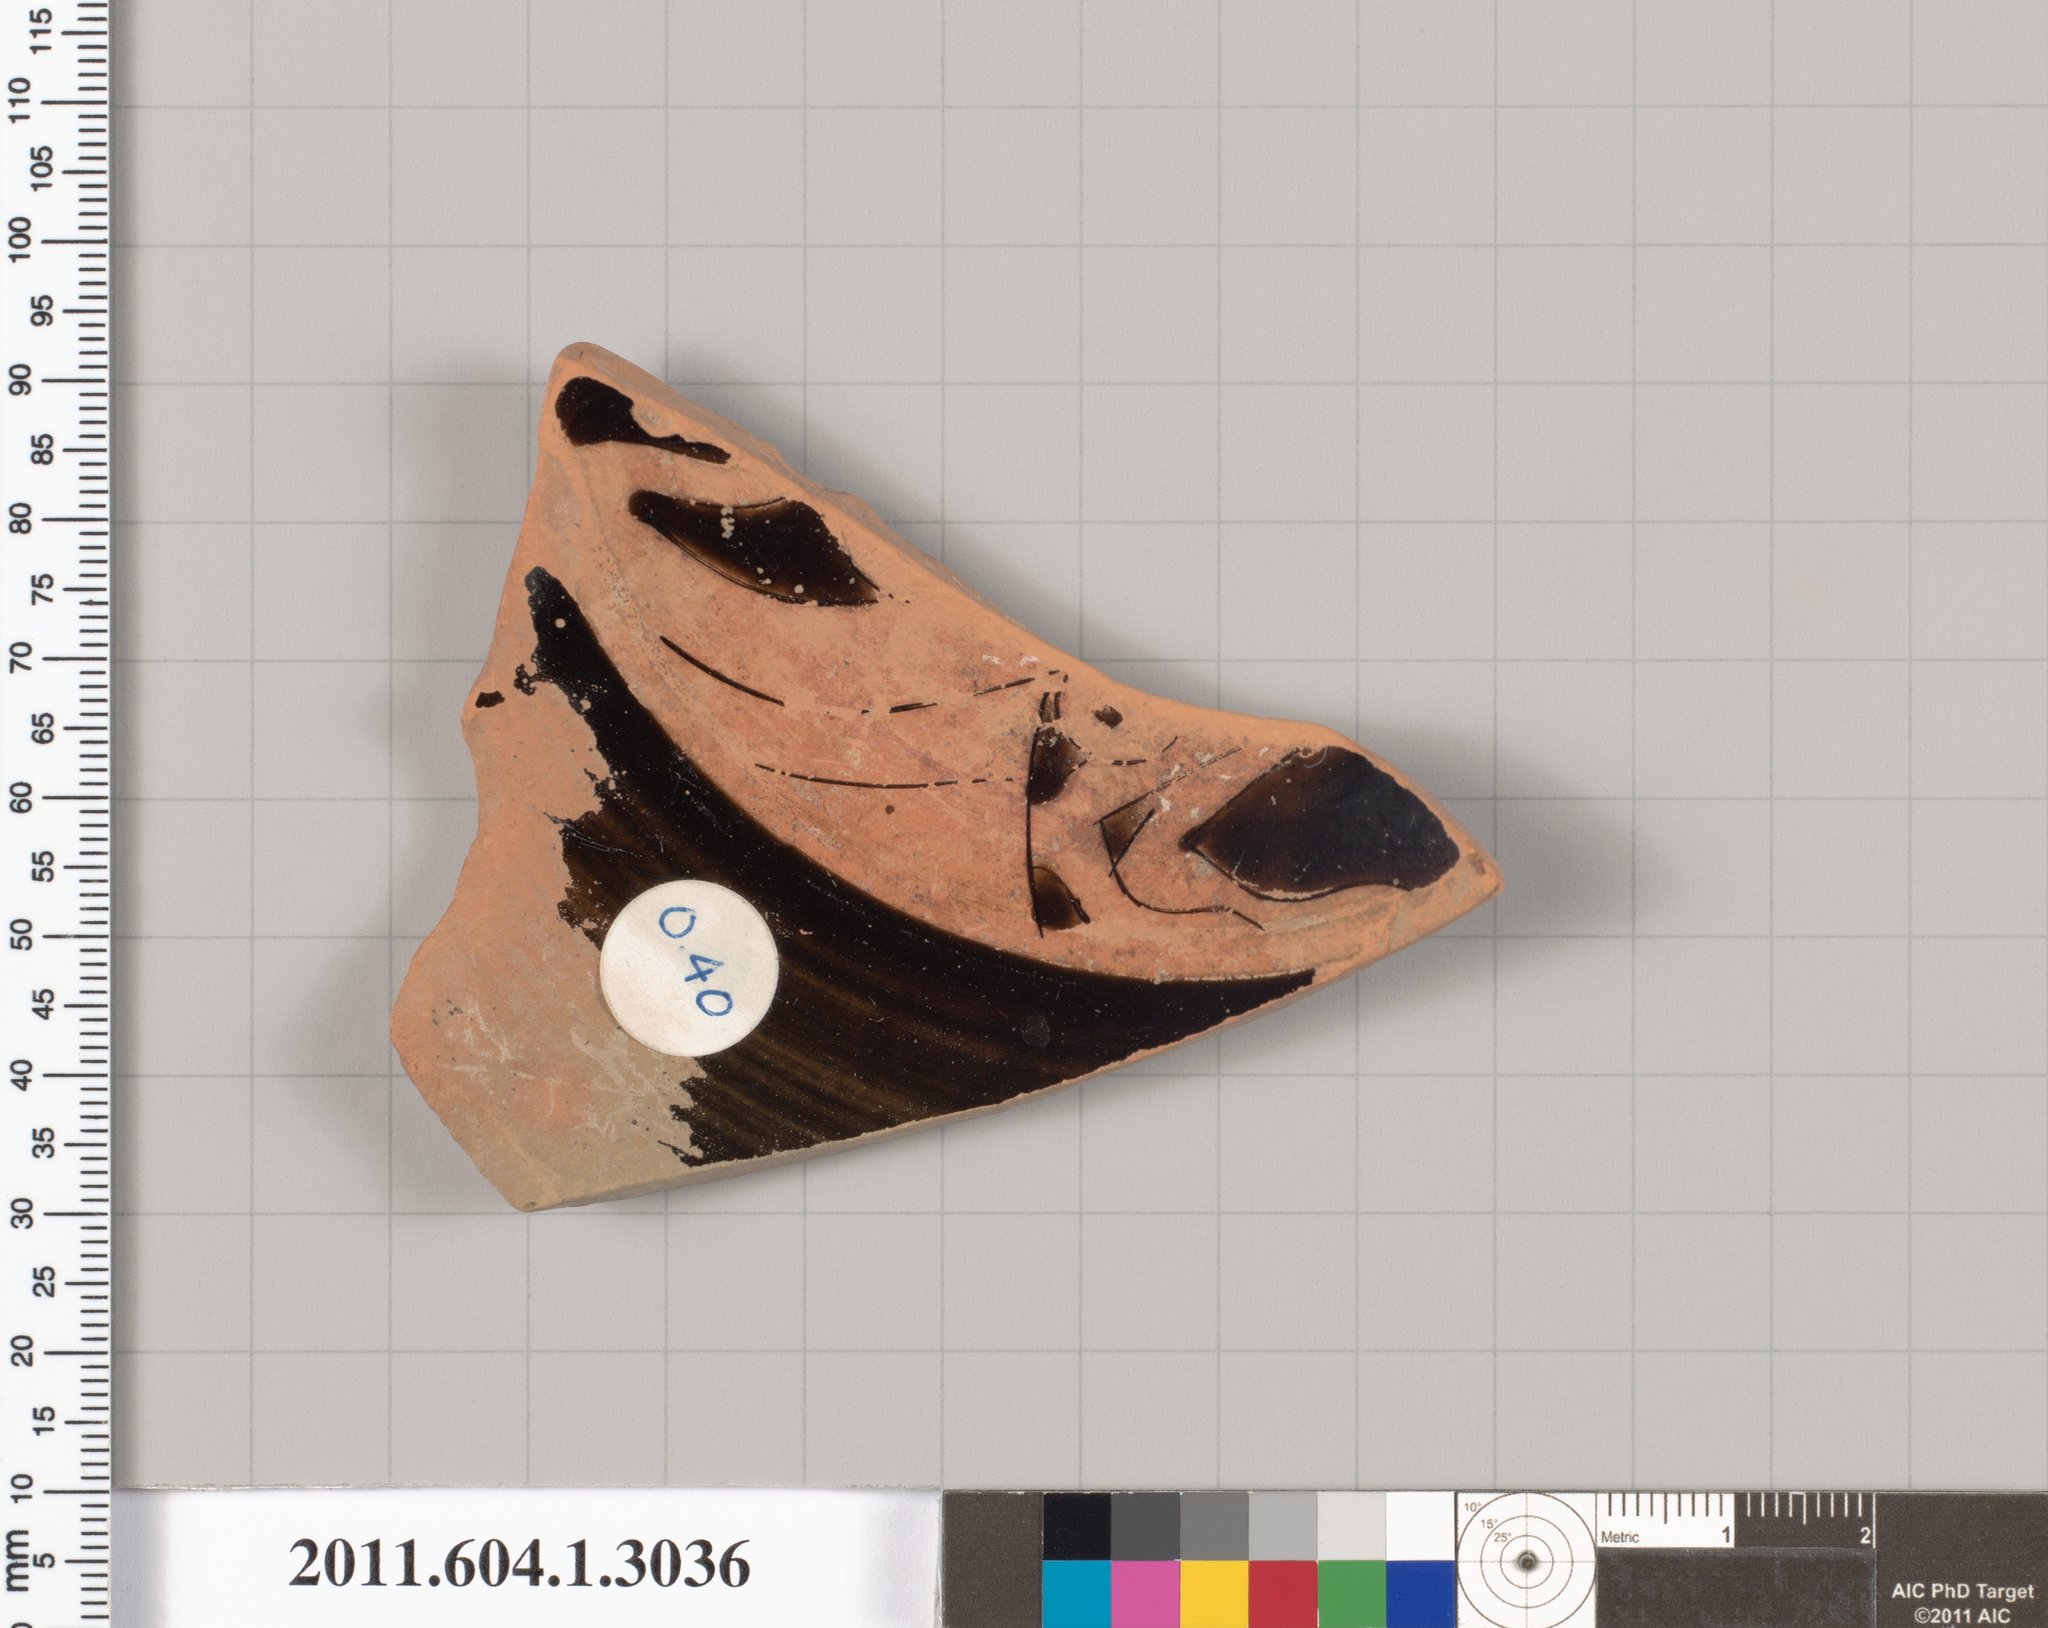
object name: kylix fragment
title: Terracotta fragment of a kylix (drinking cup)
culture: greek, attic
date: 520-500 BCE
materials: terracotta